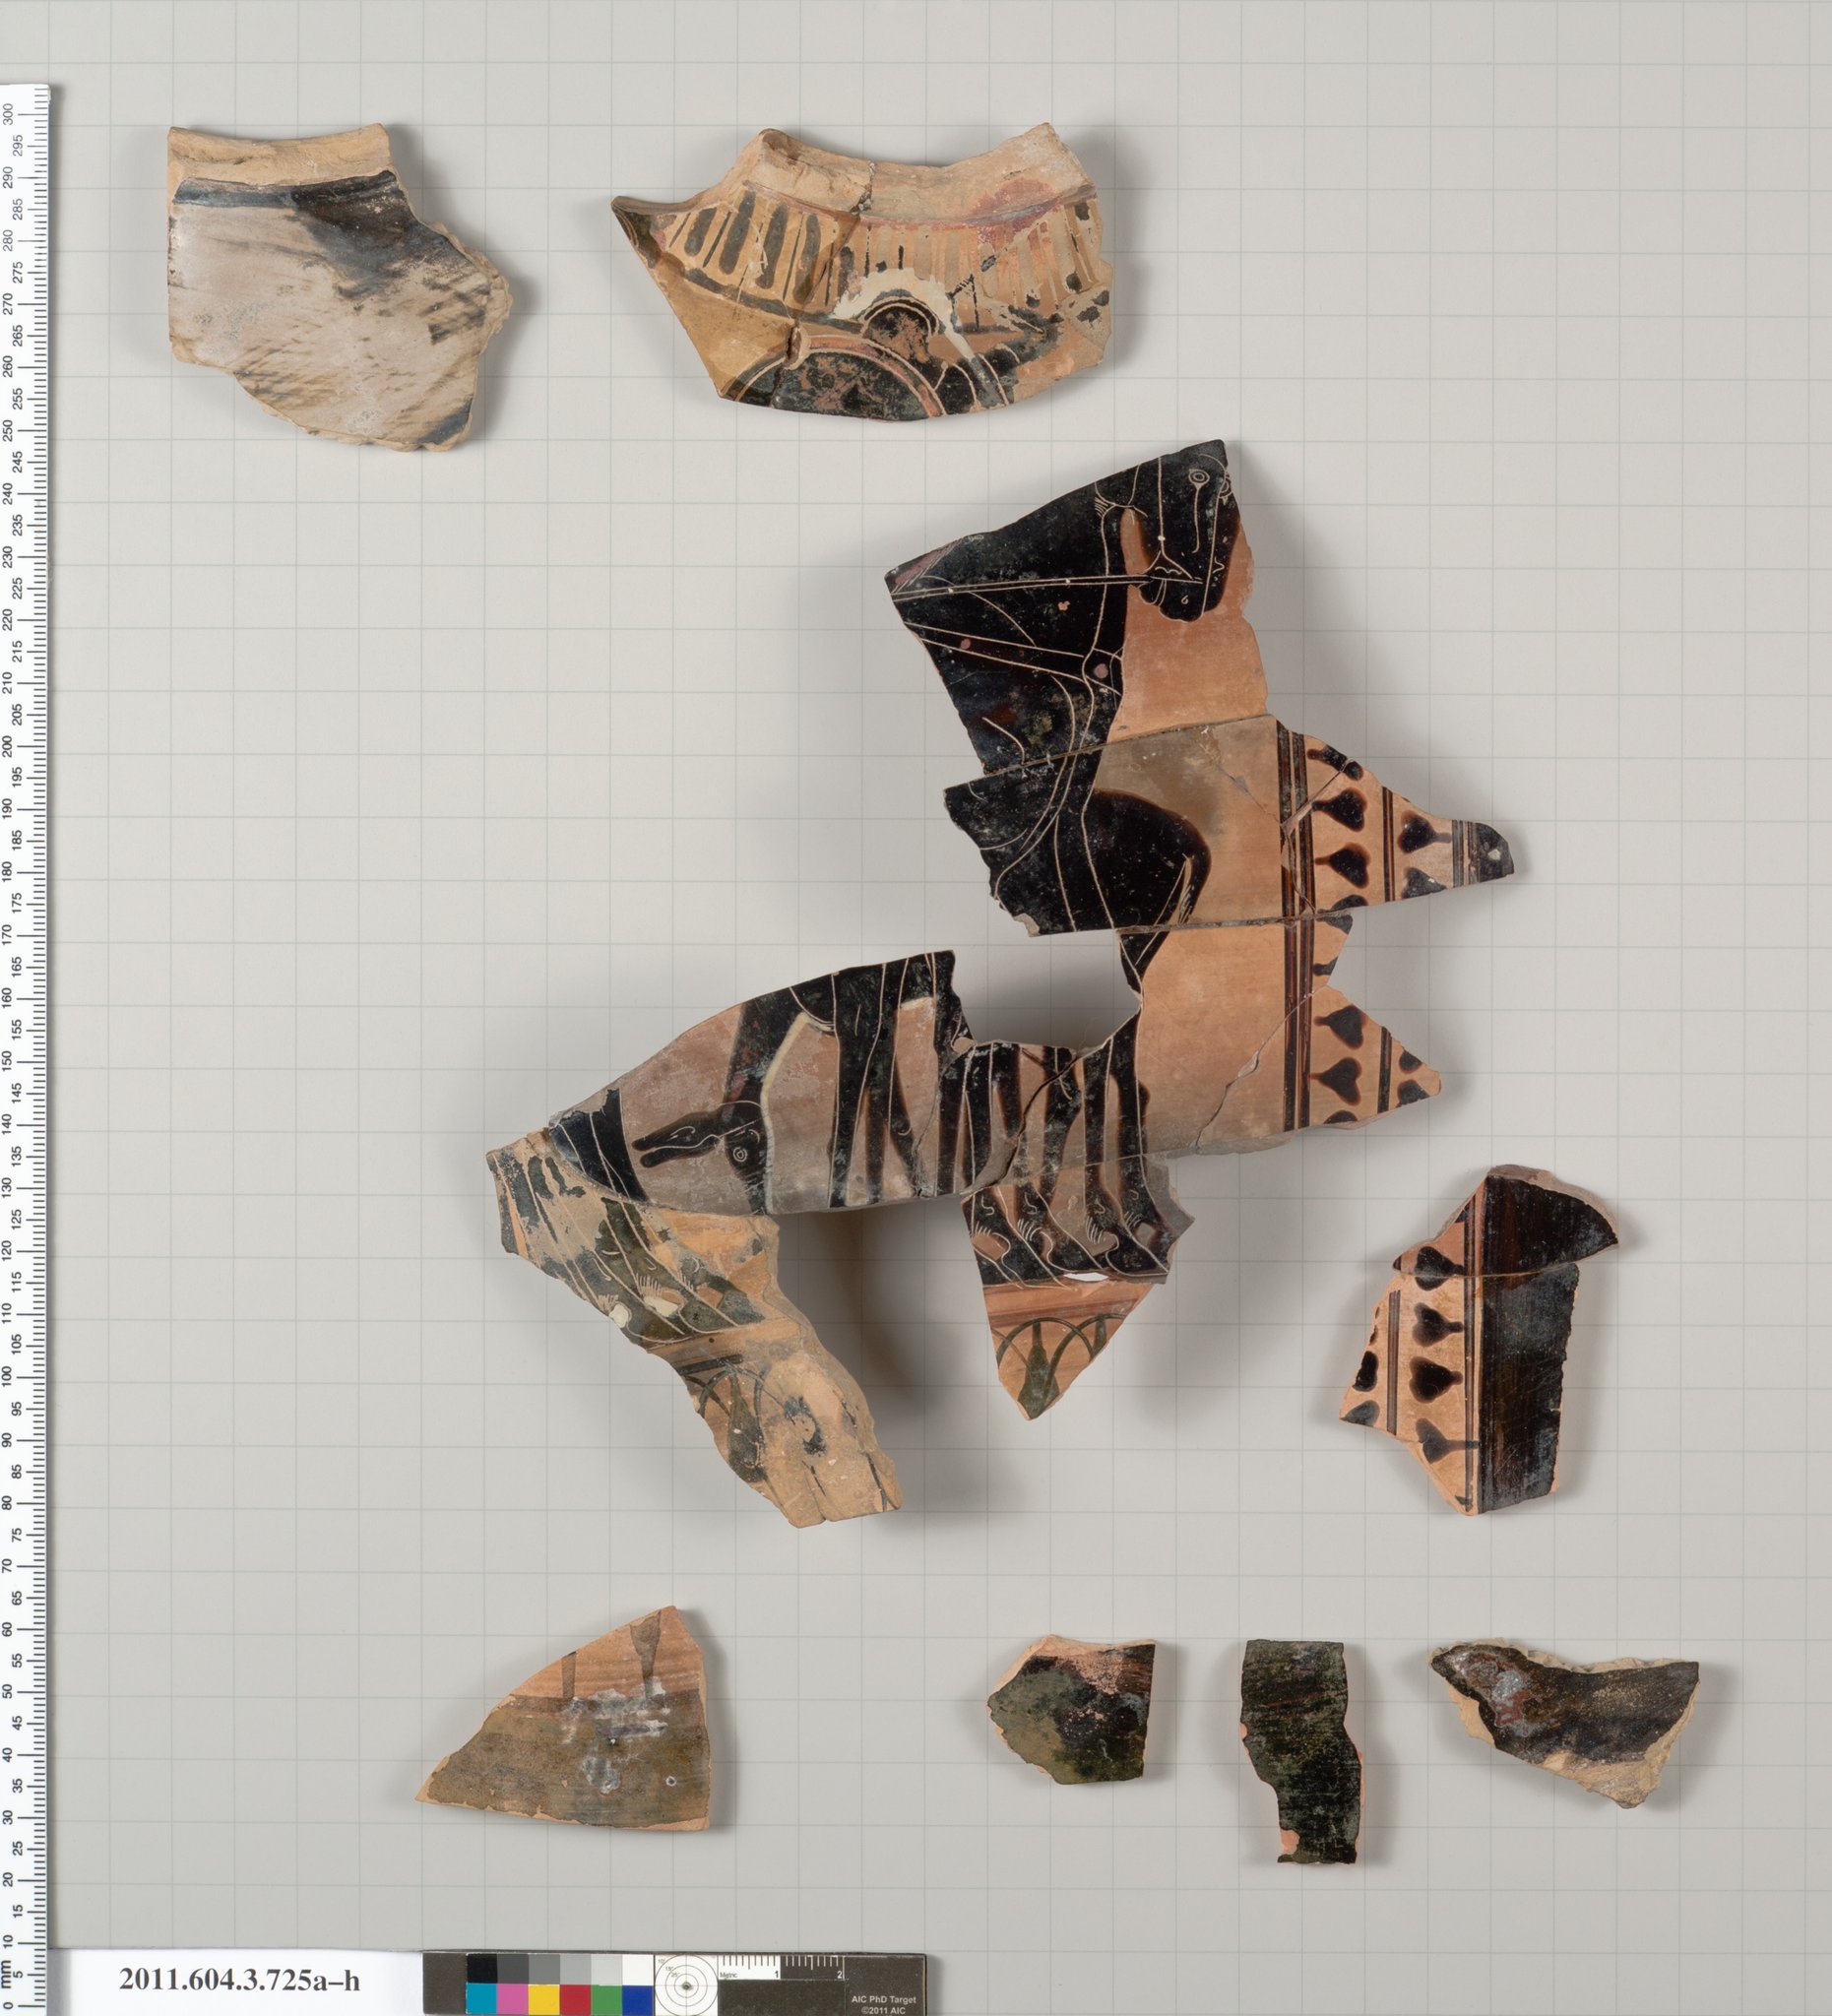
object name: hydria fragment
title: Terracotta fragments of a hydria (water jar)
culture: greek, attic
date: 550-526 BCE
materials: terracotta